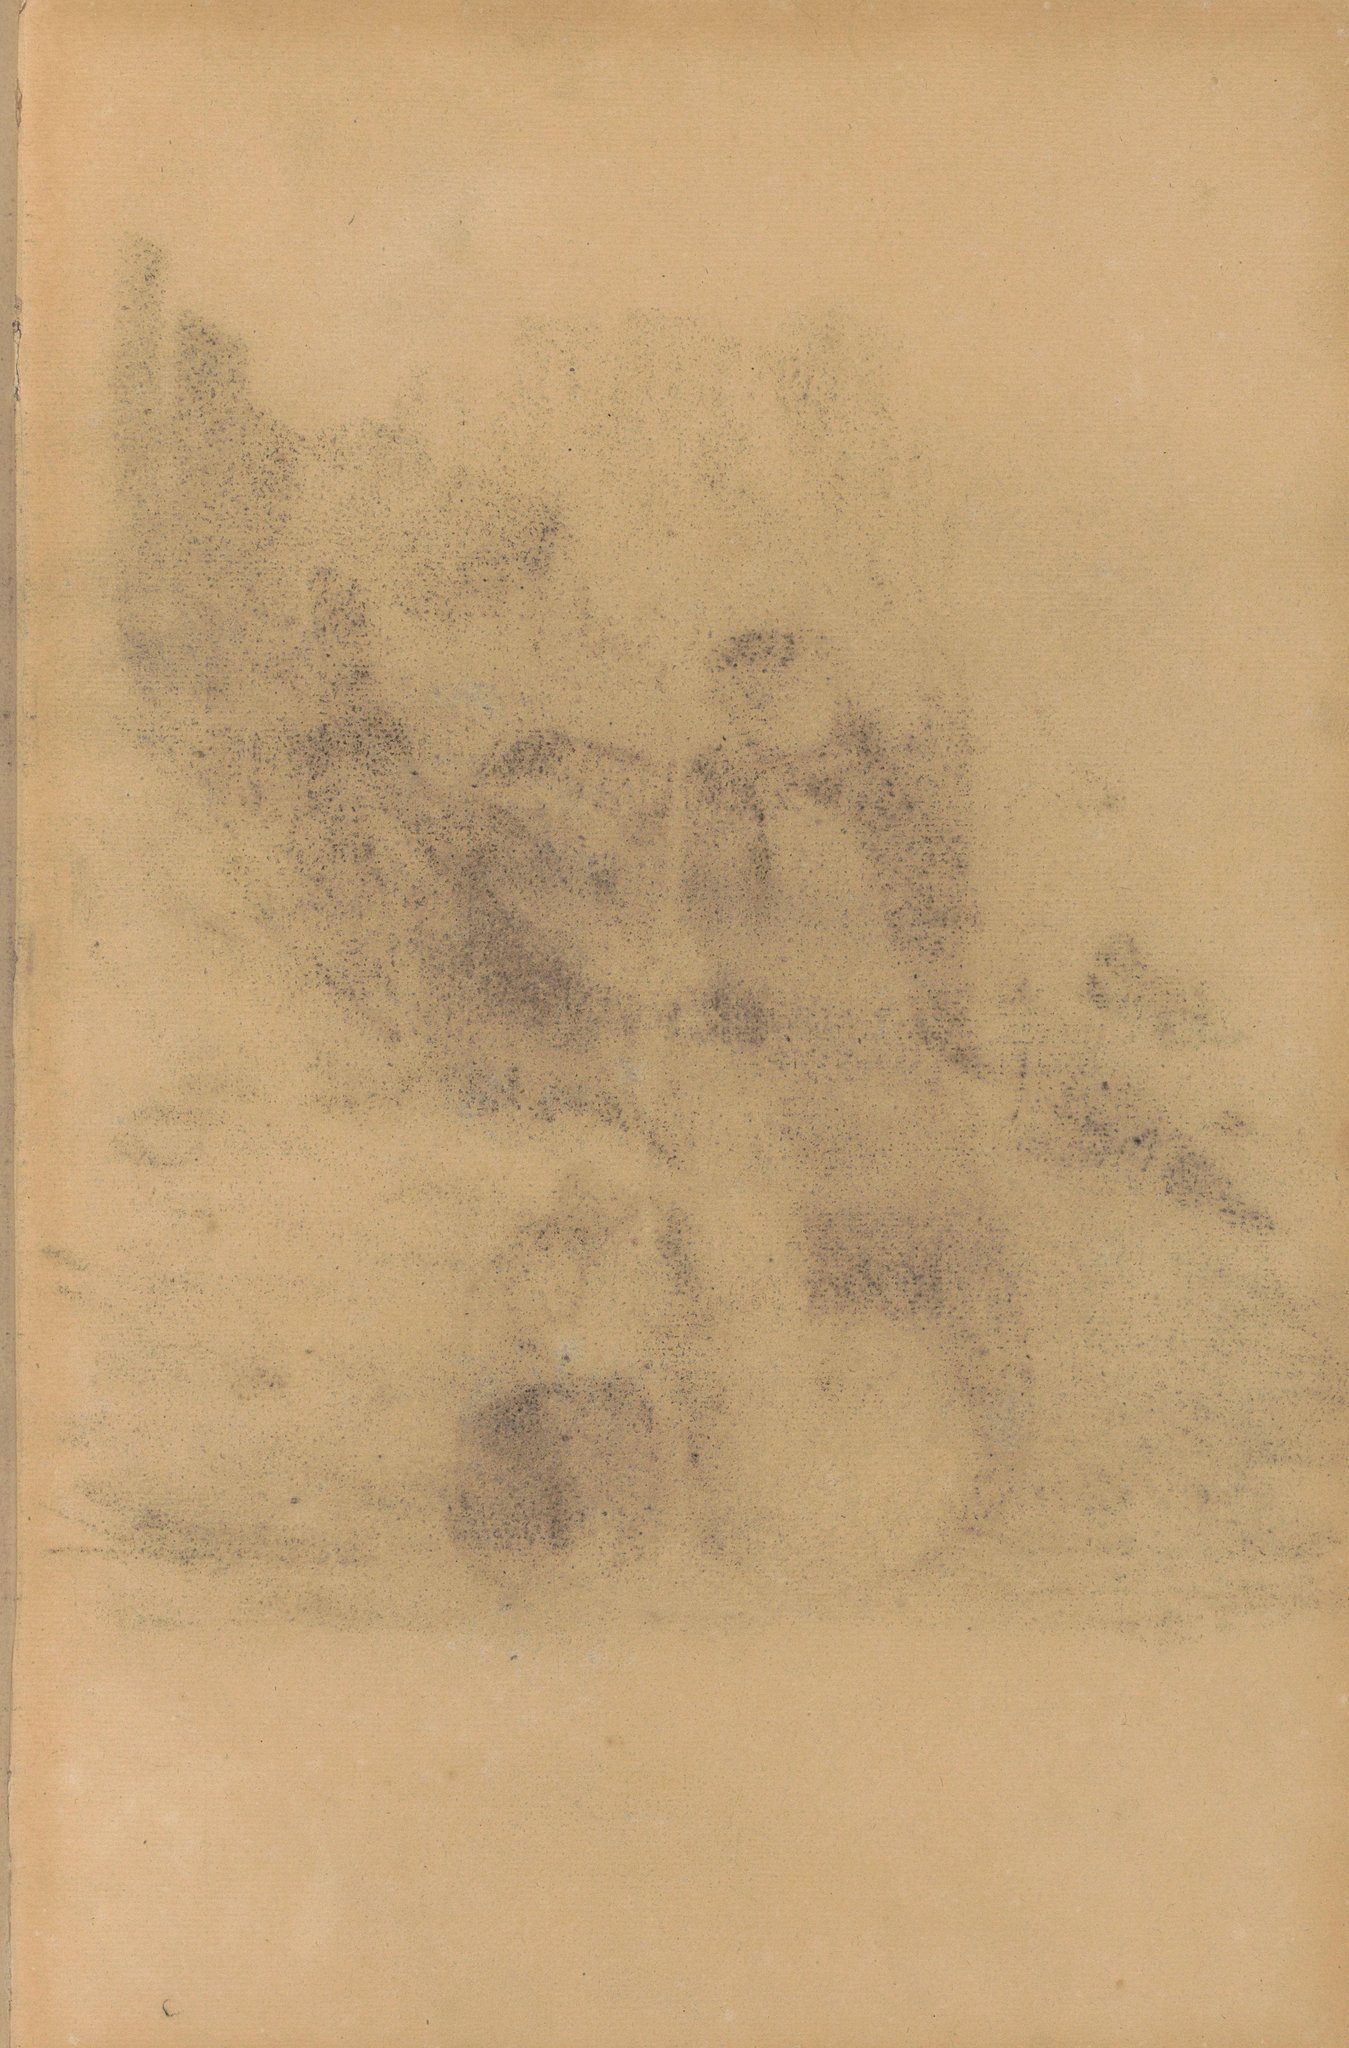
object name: sketchbook leaf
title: Abklatsch van de krijttekening op pagina 36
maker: willem witsen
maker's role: draughtsman, painter, print maker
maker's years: 1860-1923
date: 1884-1887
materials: paper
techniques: printmaking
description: Pagina 37 uit een schetsboek met 38 bladen.